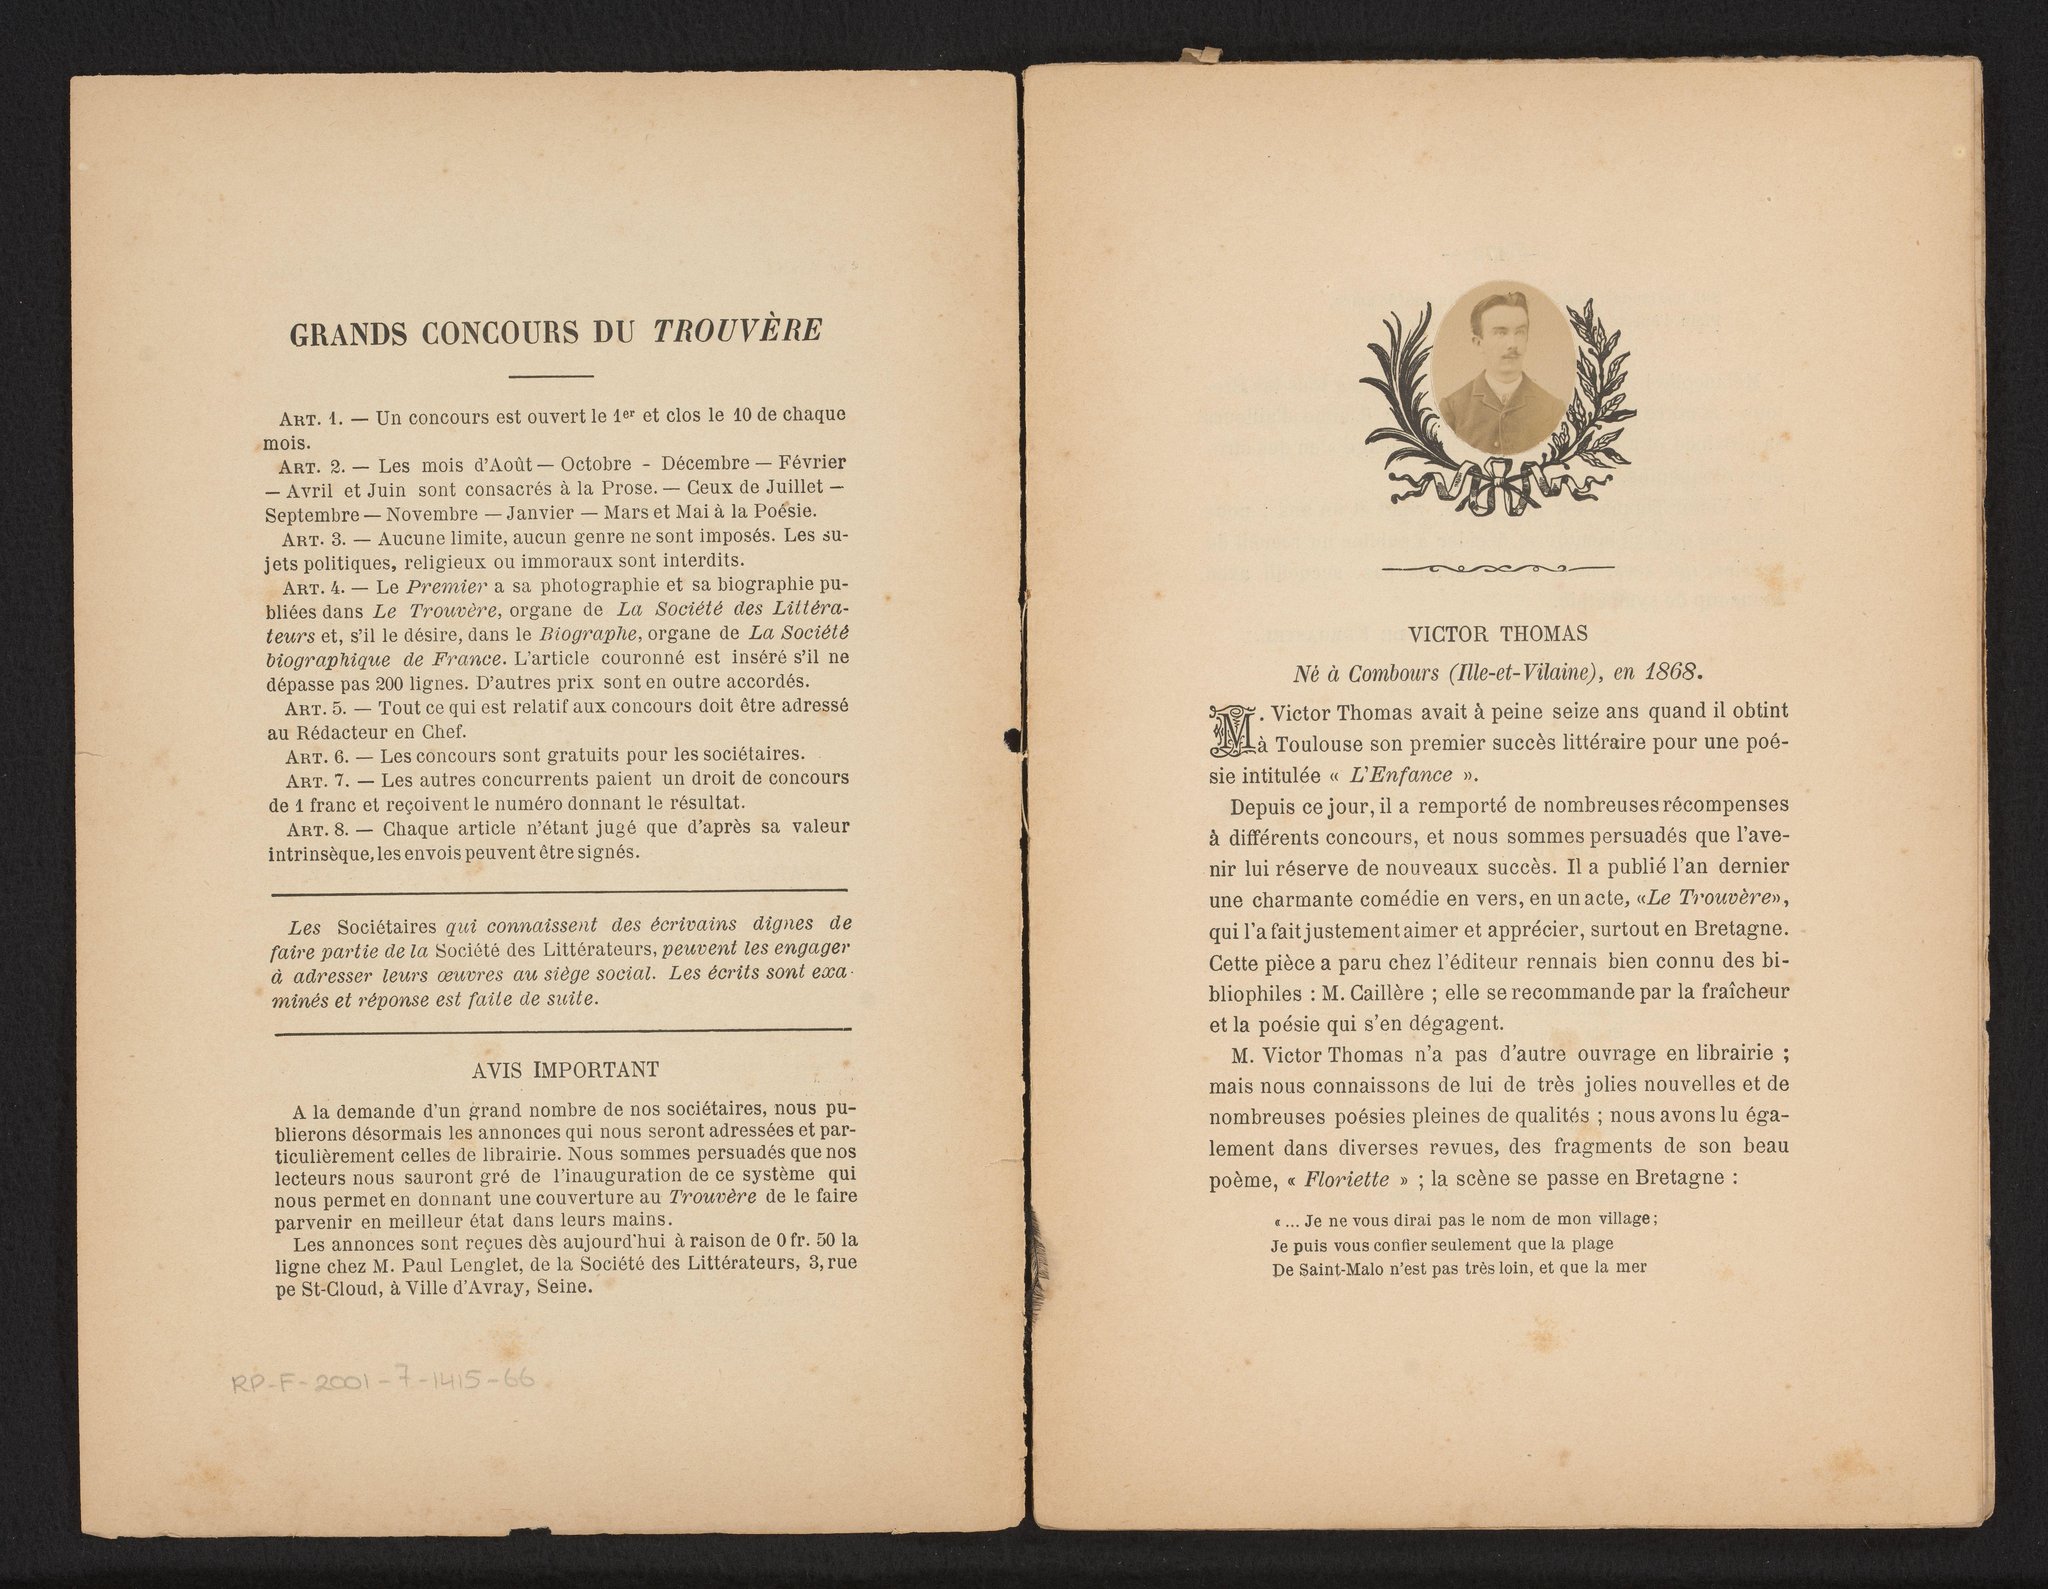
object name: page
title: Portret van Victor Thomas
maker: Anonymous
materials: photographic support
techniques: albumen print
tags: historical persons